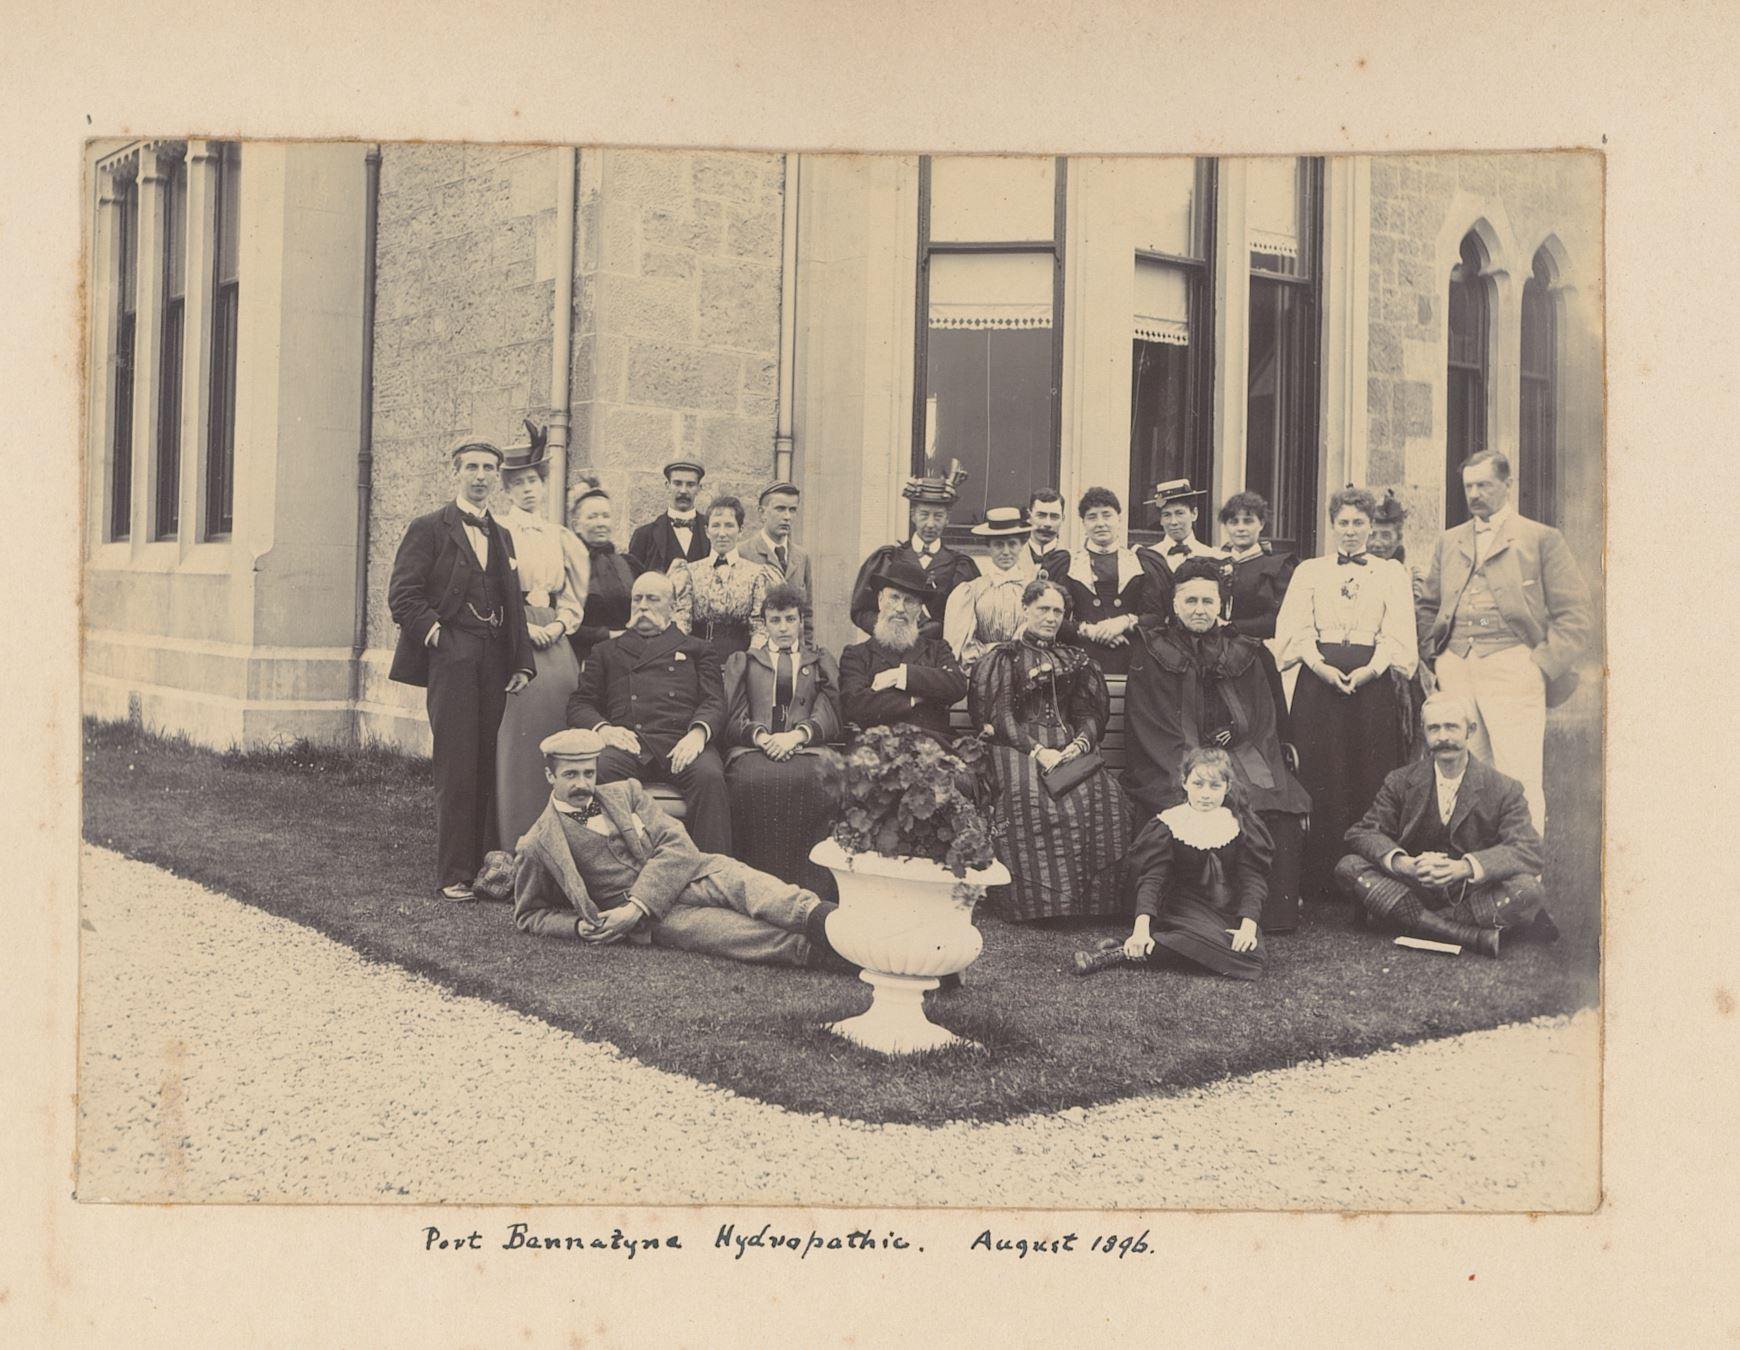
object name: photograph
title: Groepsportret van een gezelschap bij het Kyles and Bute Hydropathic te Port Bannatyne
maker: Anonymous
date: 1896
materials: cardboard, photographic support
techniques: gelatin silver print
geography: kyles of bute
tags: anonymous historical persons portrayed in a group, in a group-portrait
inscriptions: annotation: ‘Port Bannatyne Hydropathic. August 1896.’